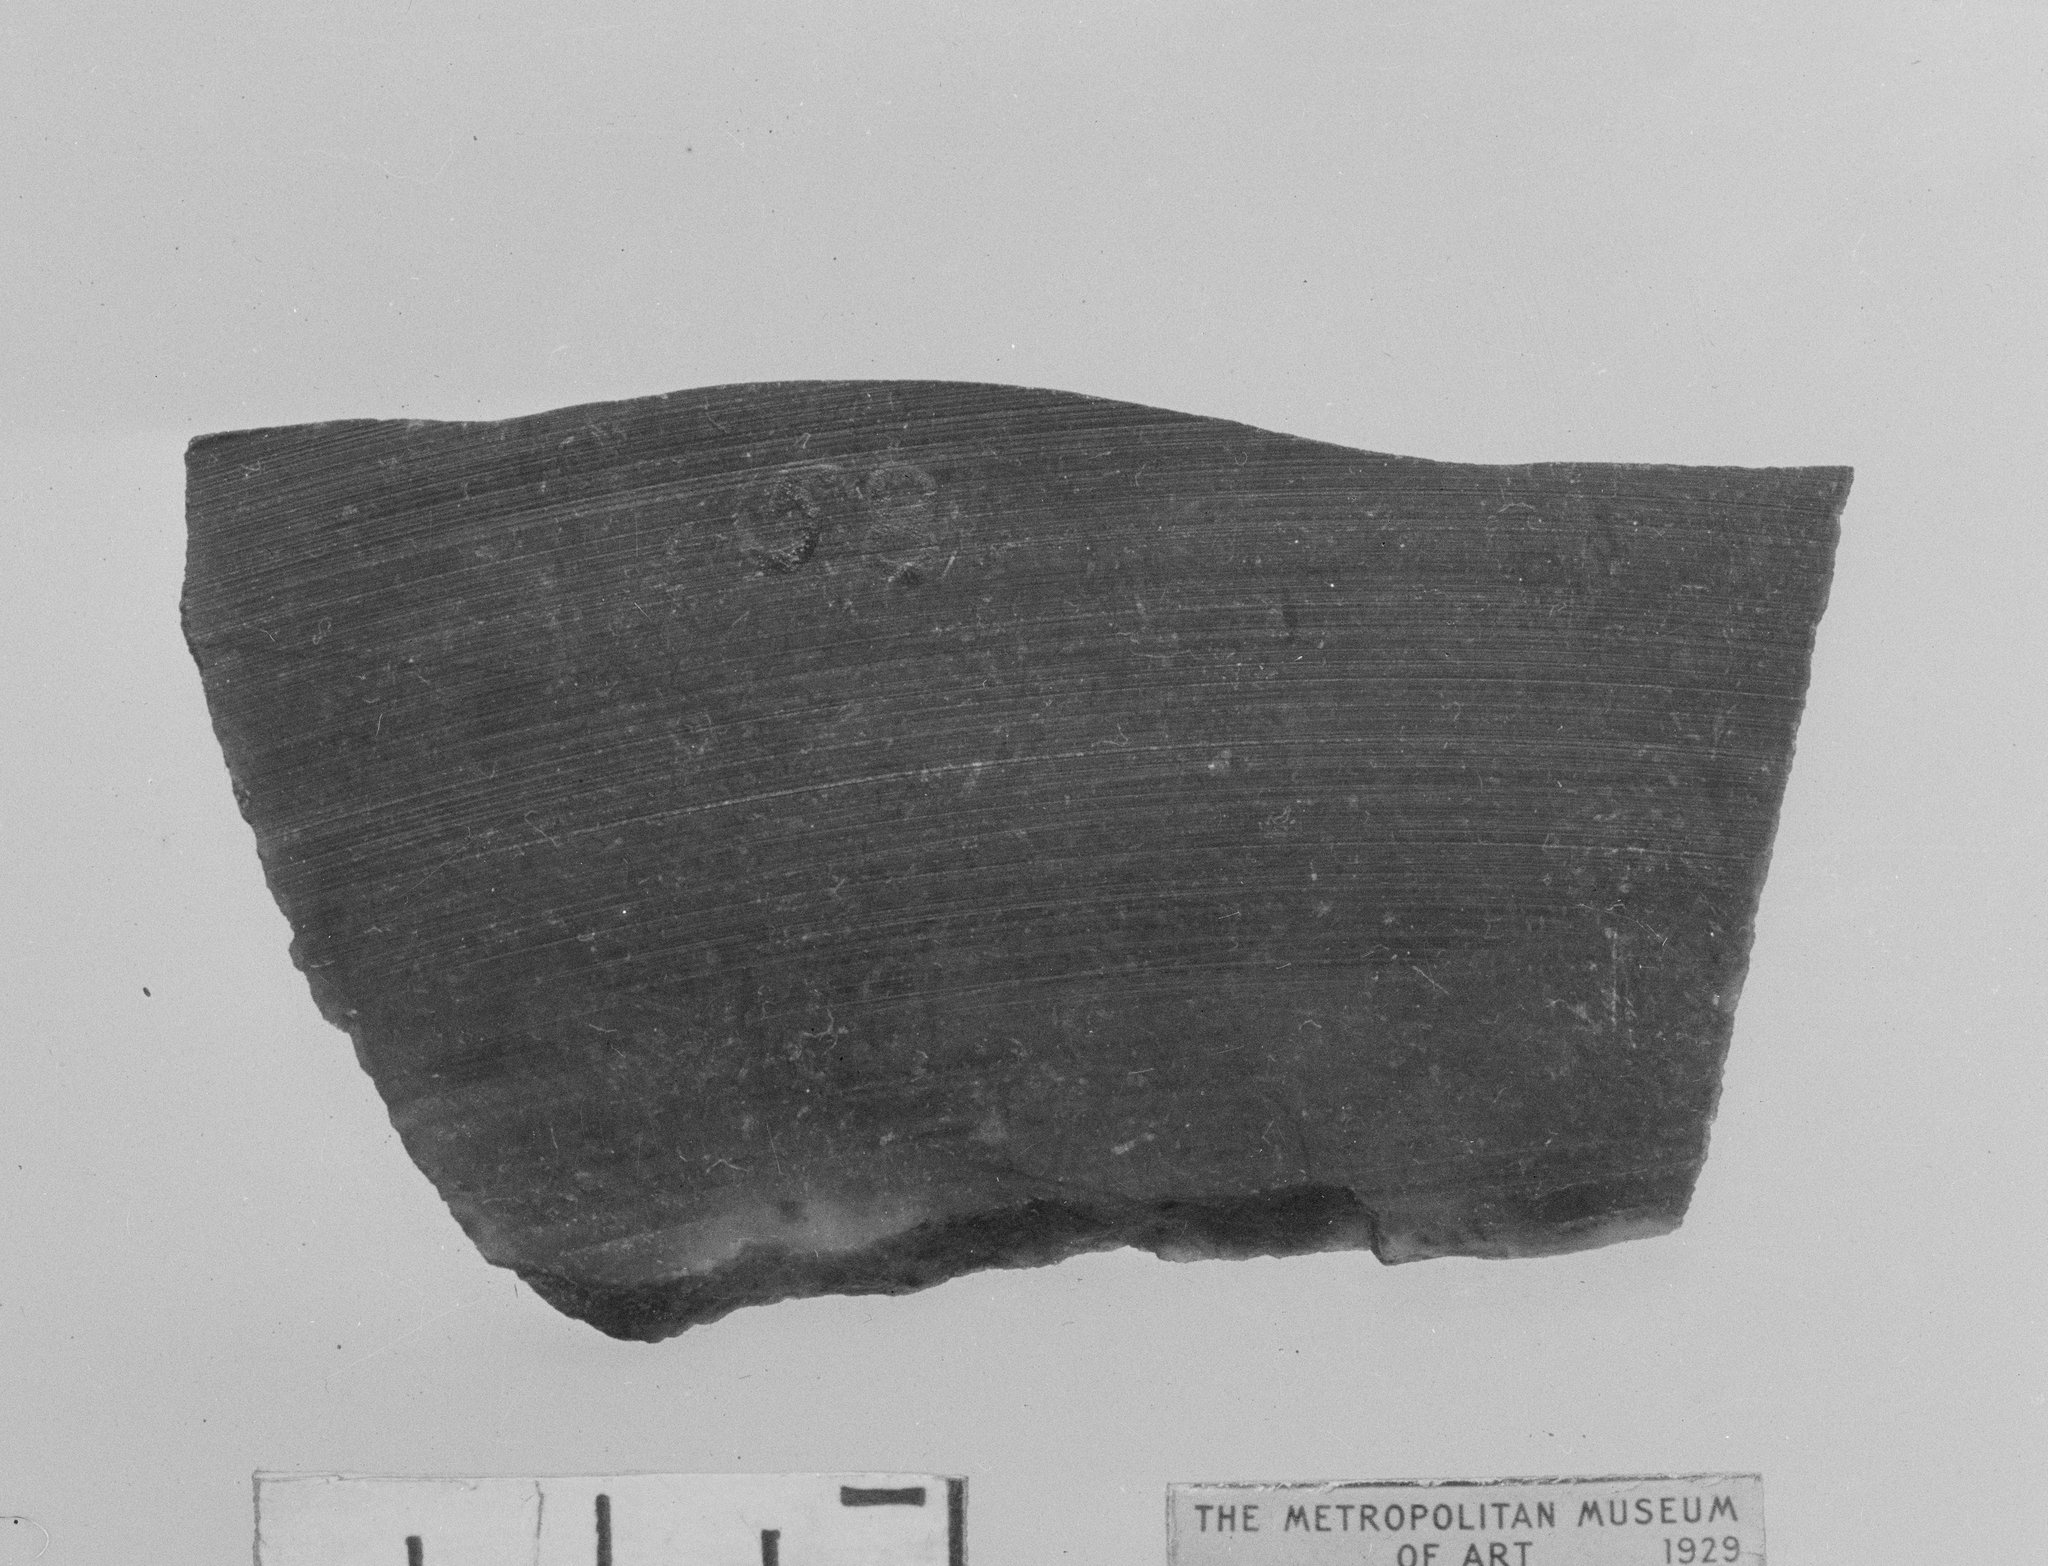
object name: fragment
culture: tibetan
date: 1902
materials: jade